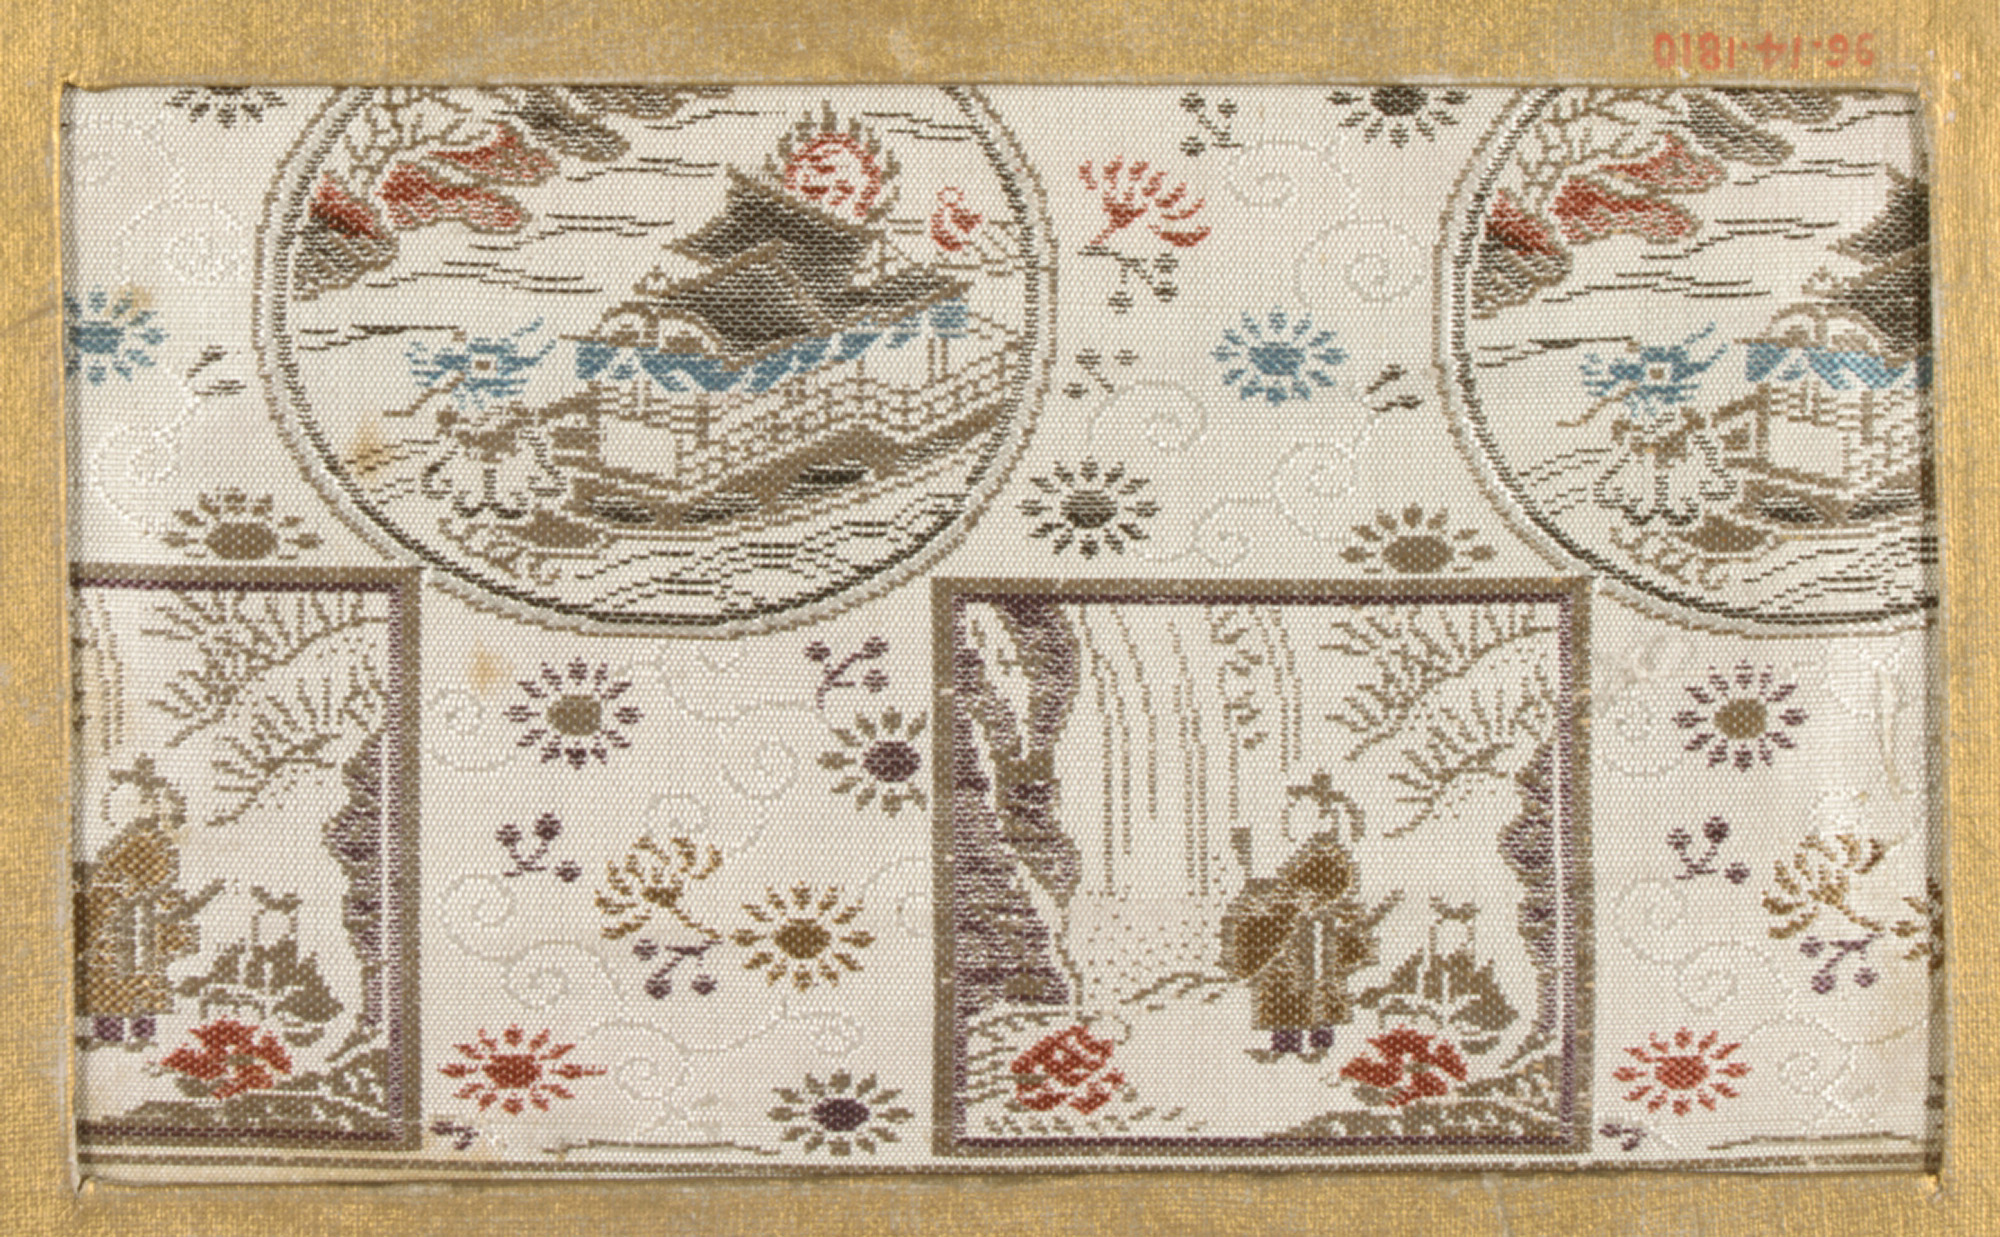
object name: piece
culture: japanese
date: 1701-1900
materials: silk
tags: human figures,houses